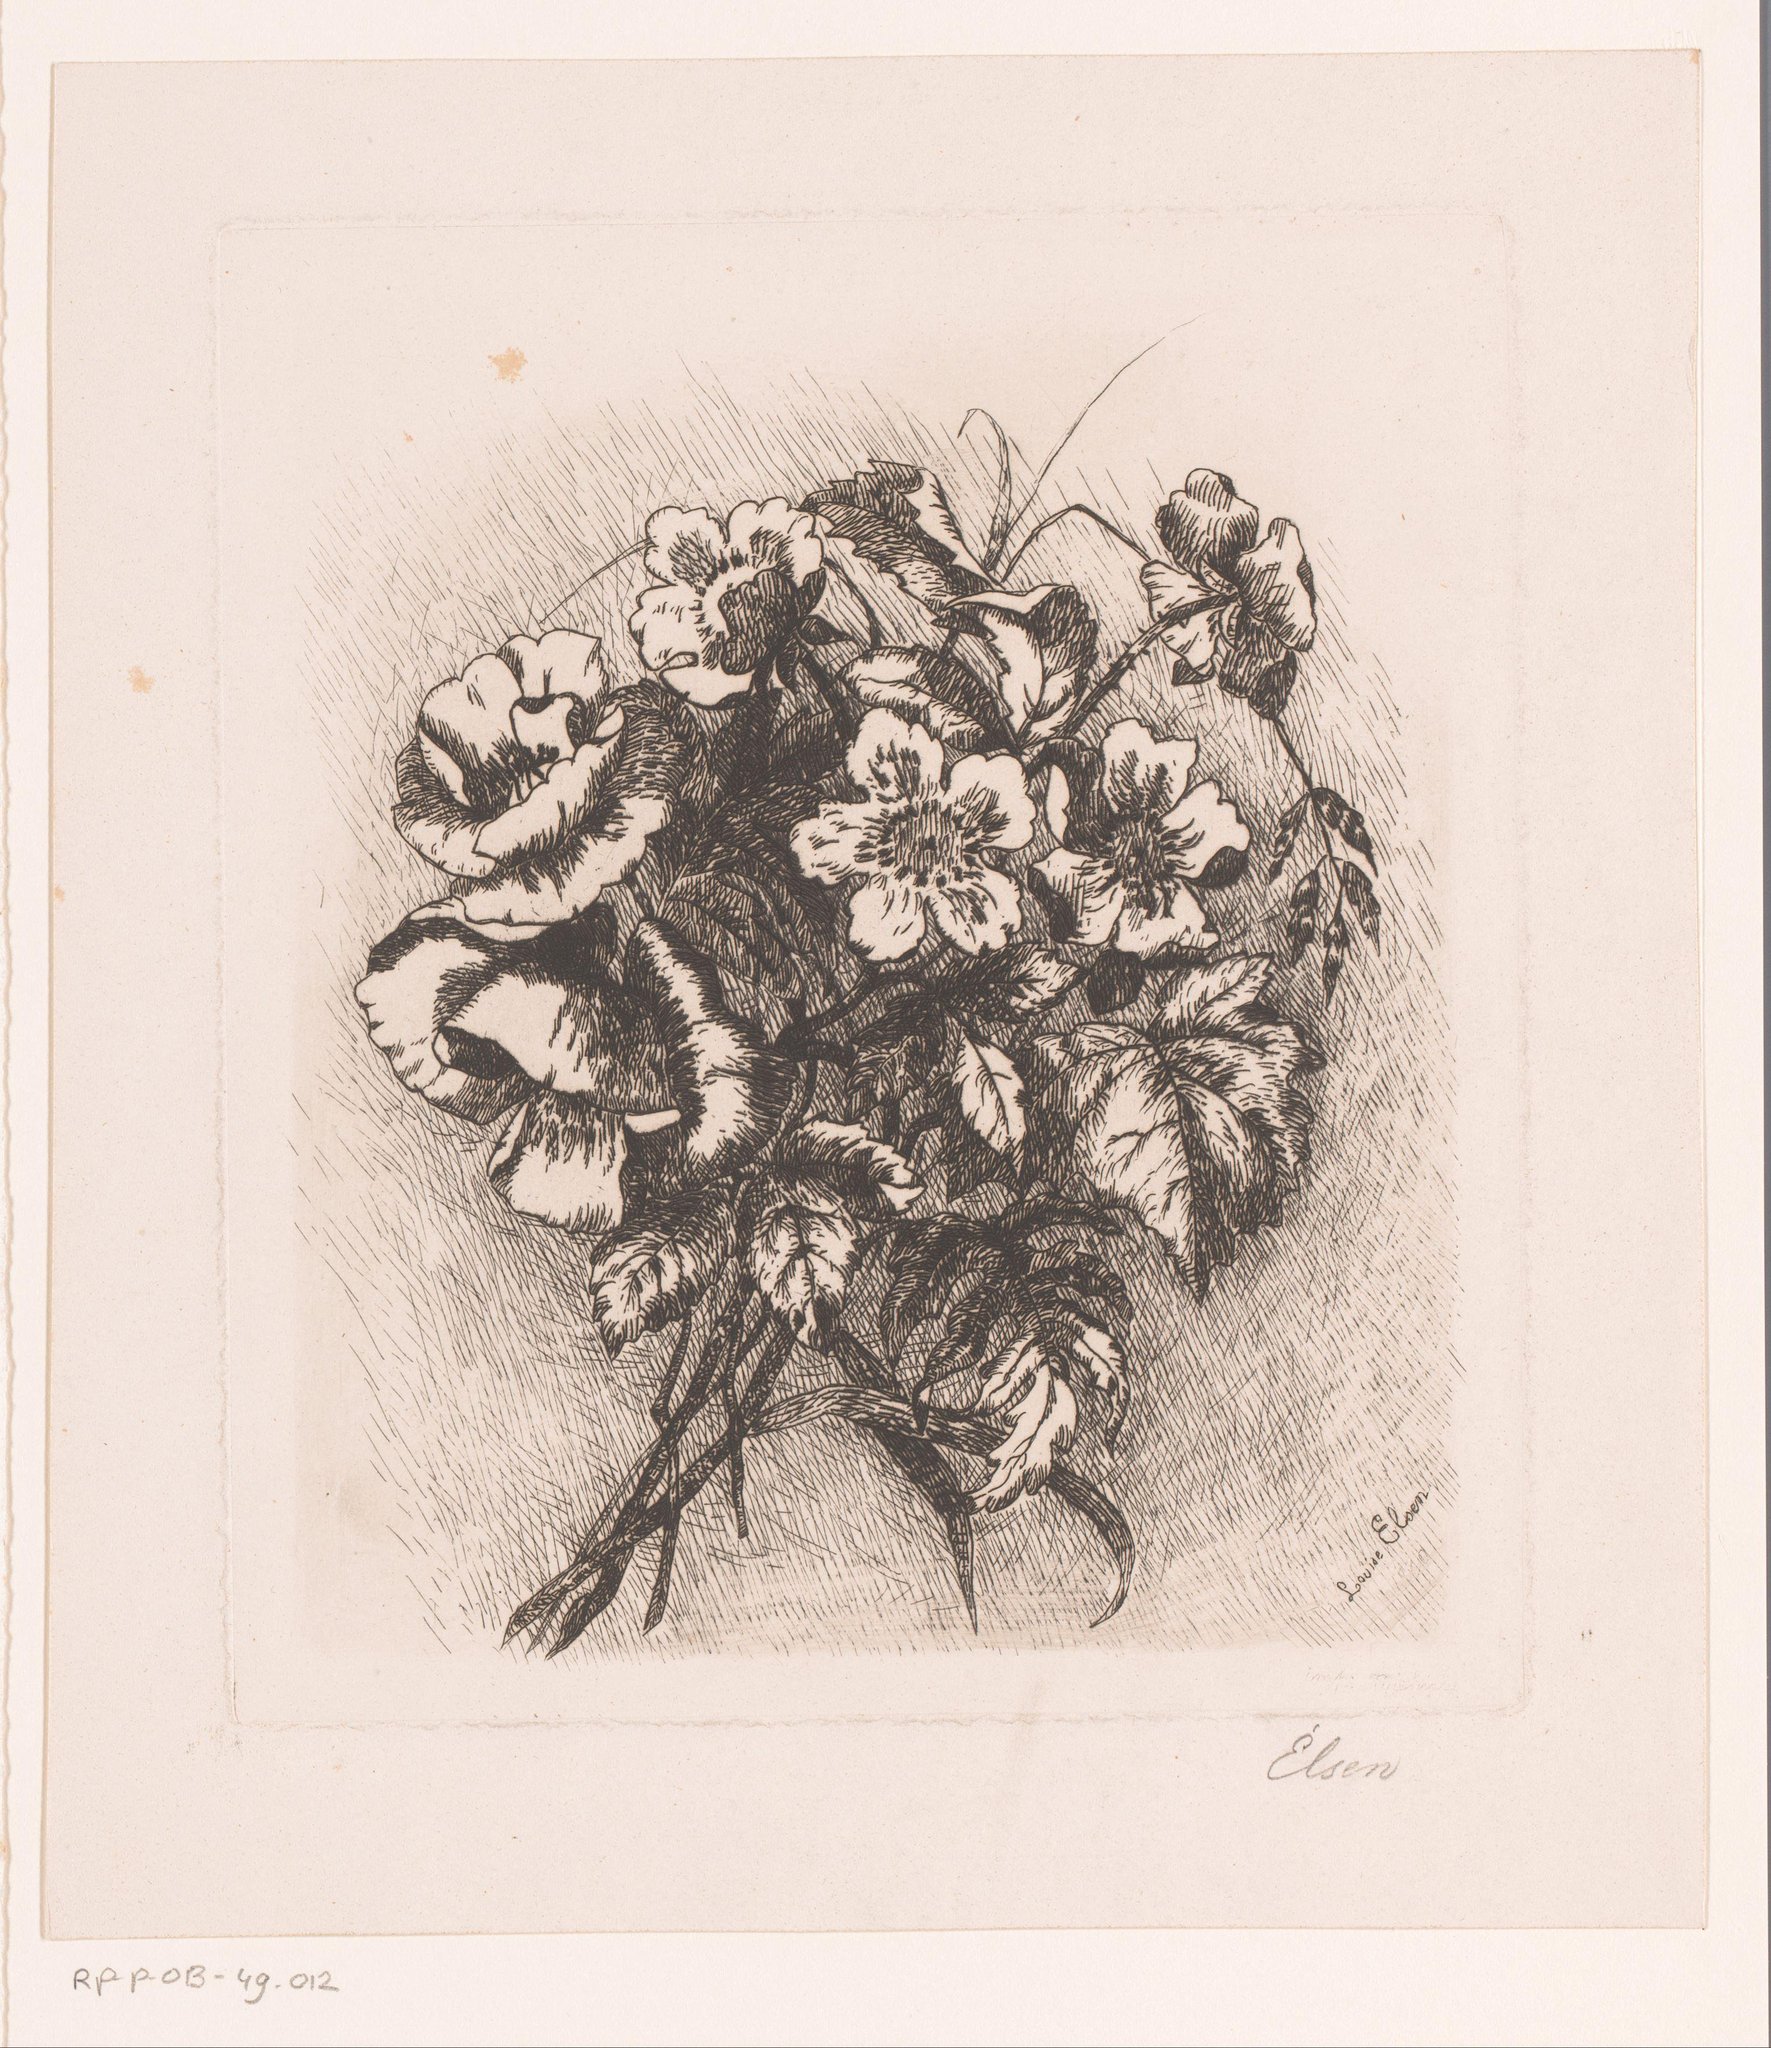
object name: print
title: Bloemstilleven met klaprozen en anemonen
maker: louise elsen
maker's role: print maker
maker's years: 1853-1937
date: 1880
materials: paper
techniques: etching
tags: flowers: anemone, still life of plants, flowers and fruit, flowers: rose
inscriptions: collector's mark: Lugt 2228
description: Onder andere twee grote klaprozen links en drie anemonen in het midden.